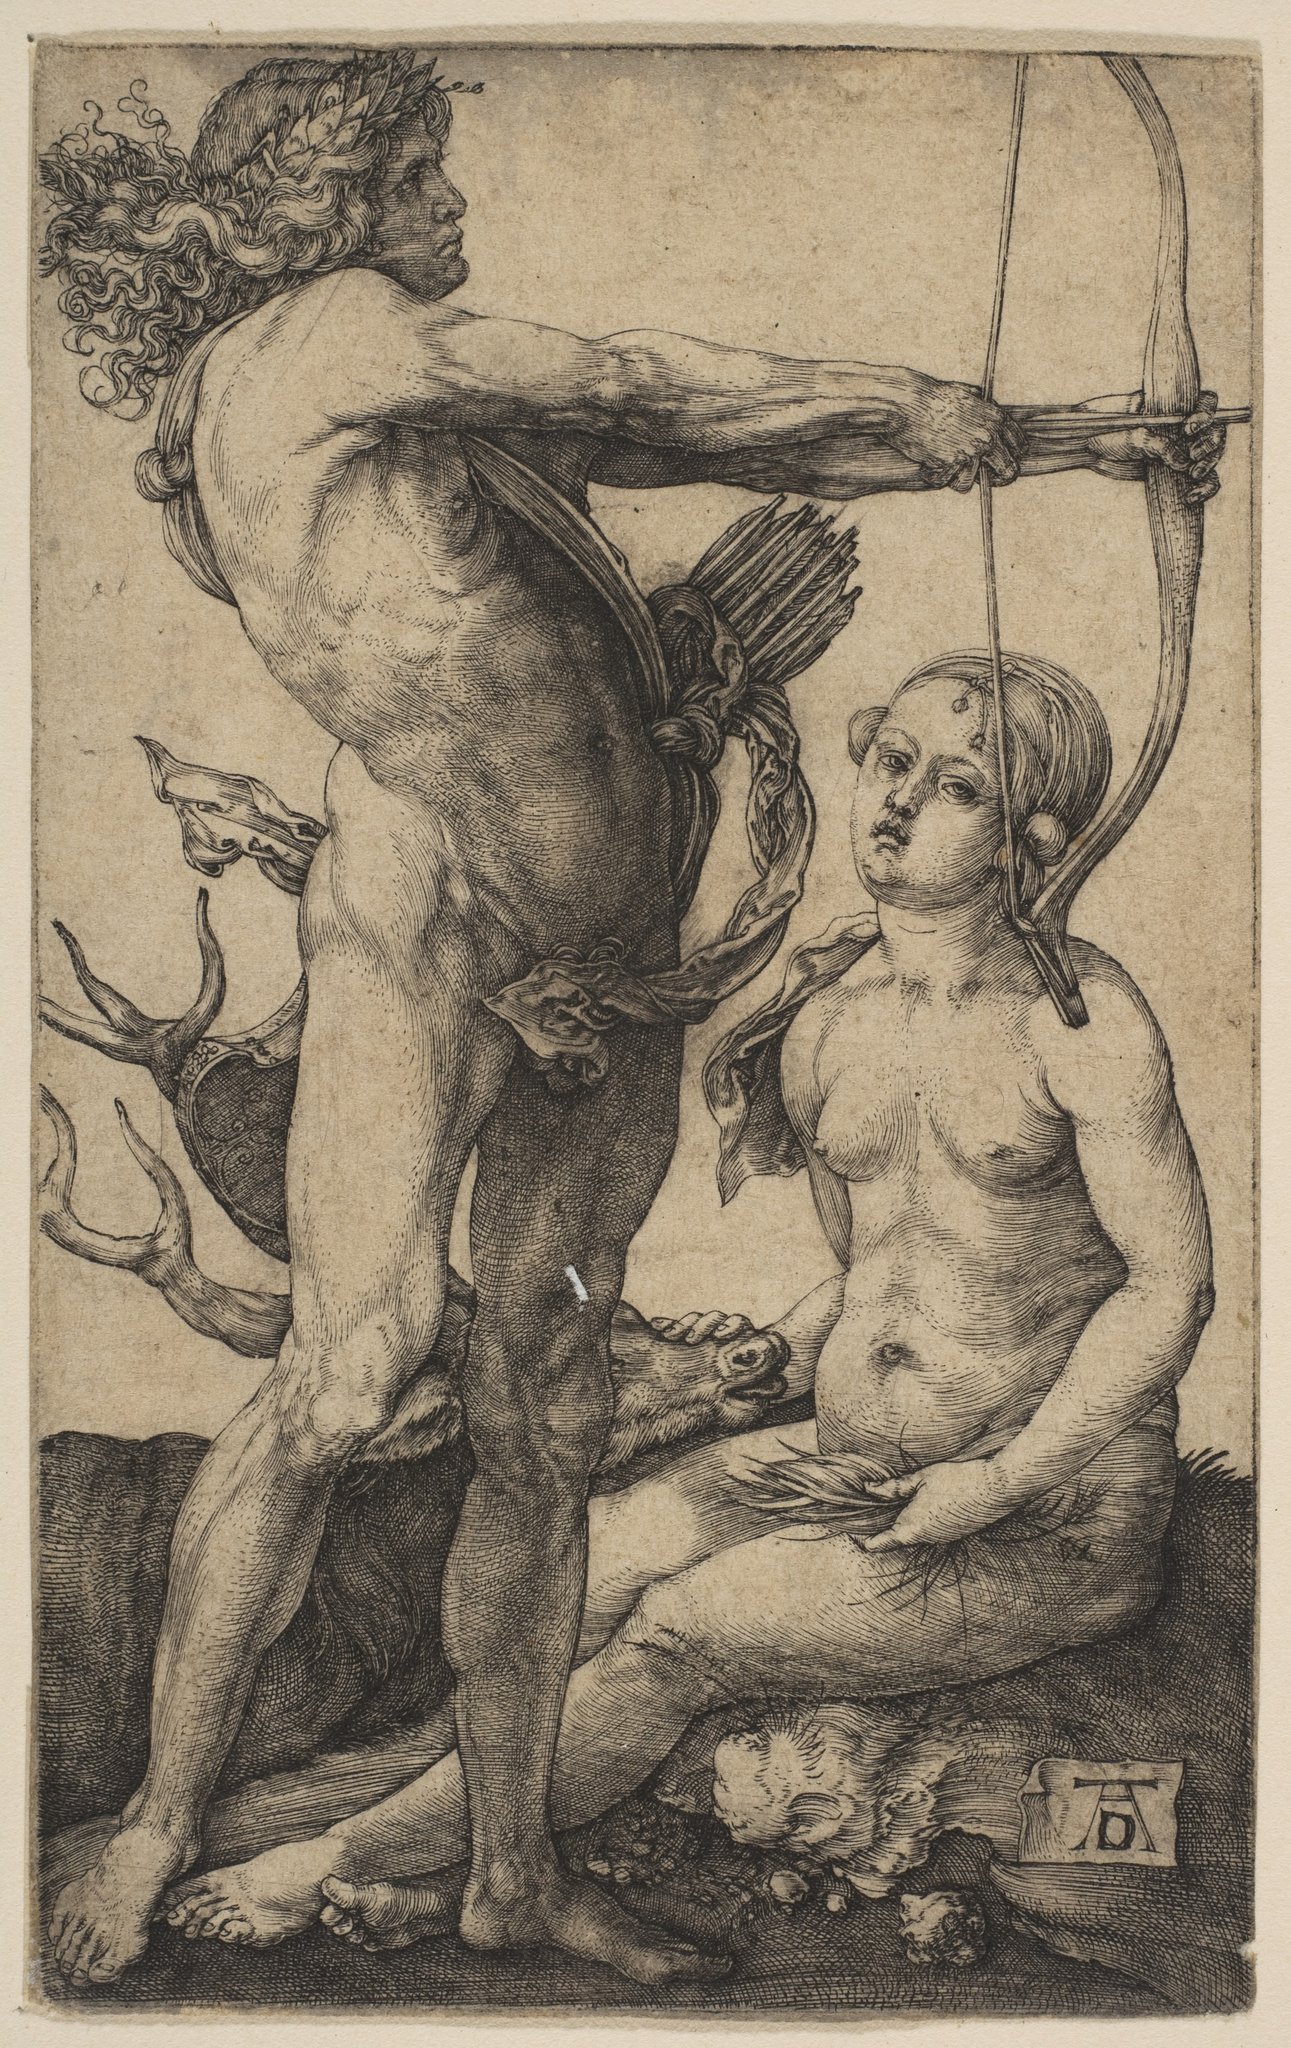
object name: print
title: Apollo and Diana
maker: albrecht dürer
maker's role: artist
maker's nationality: german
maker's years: 1471-1528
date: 1503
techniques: engraving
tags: bow and arrow,apollo,diana